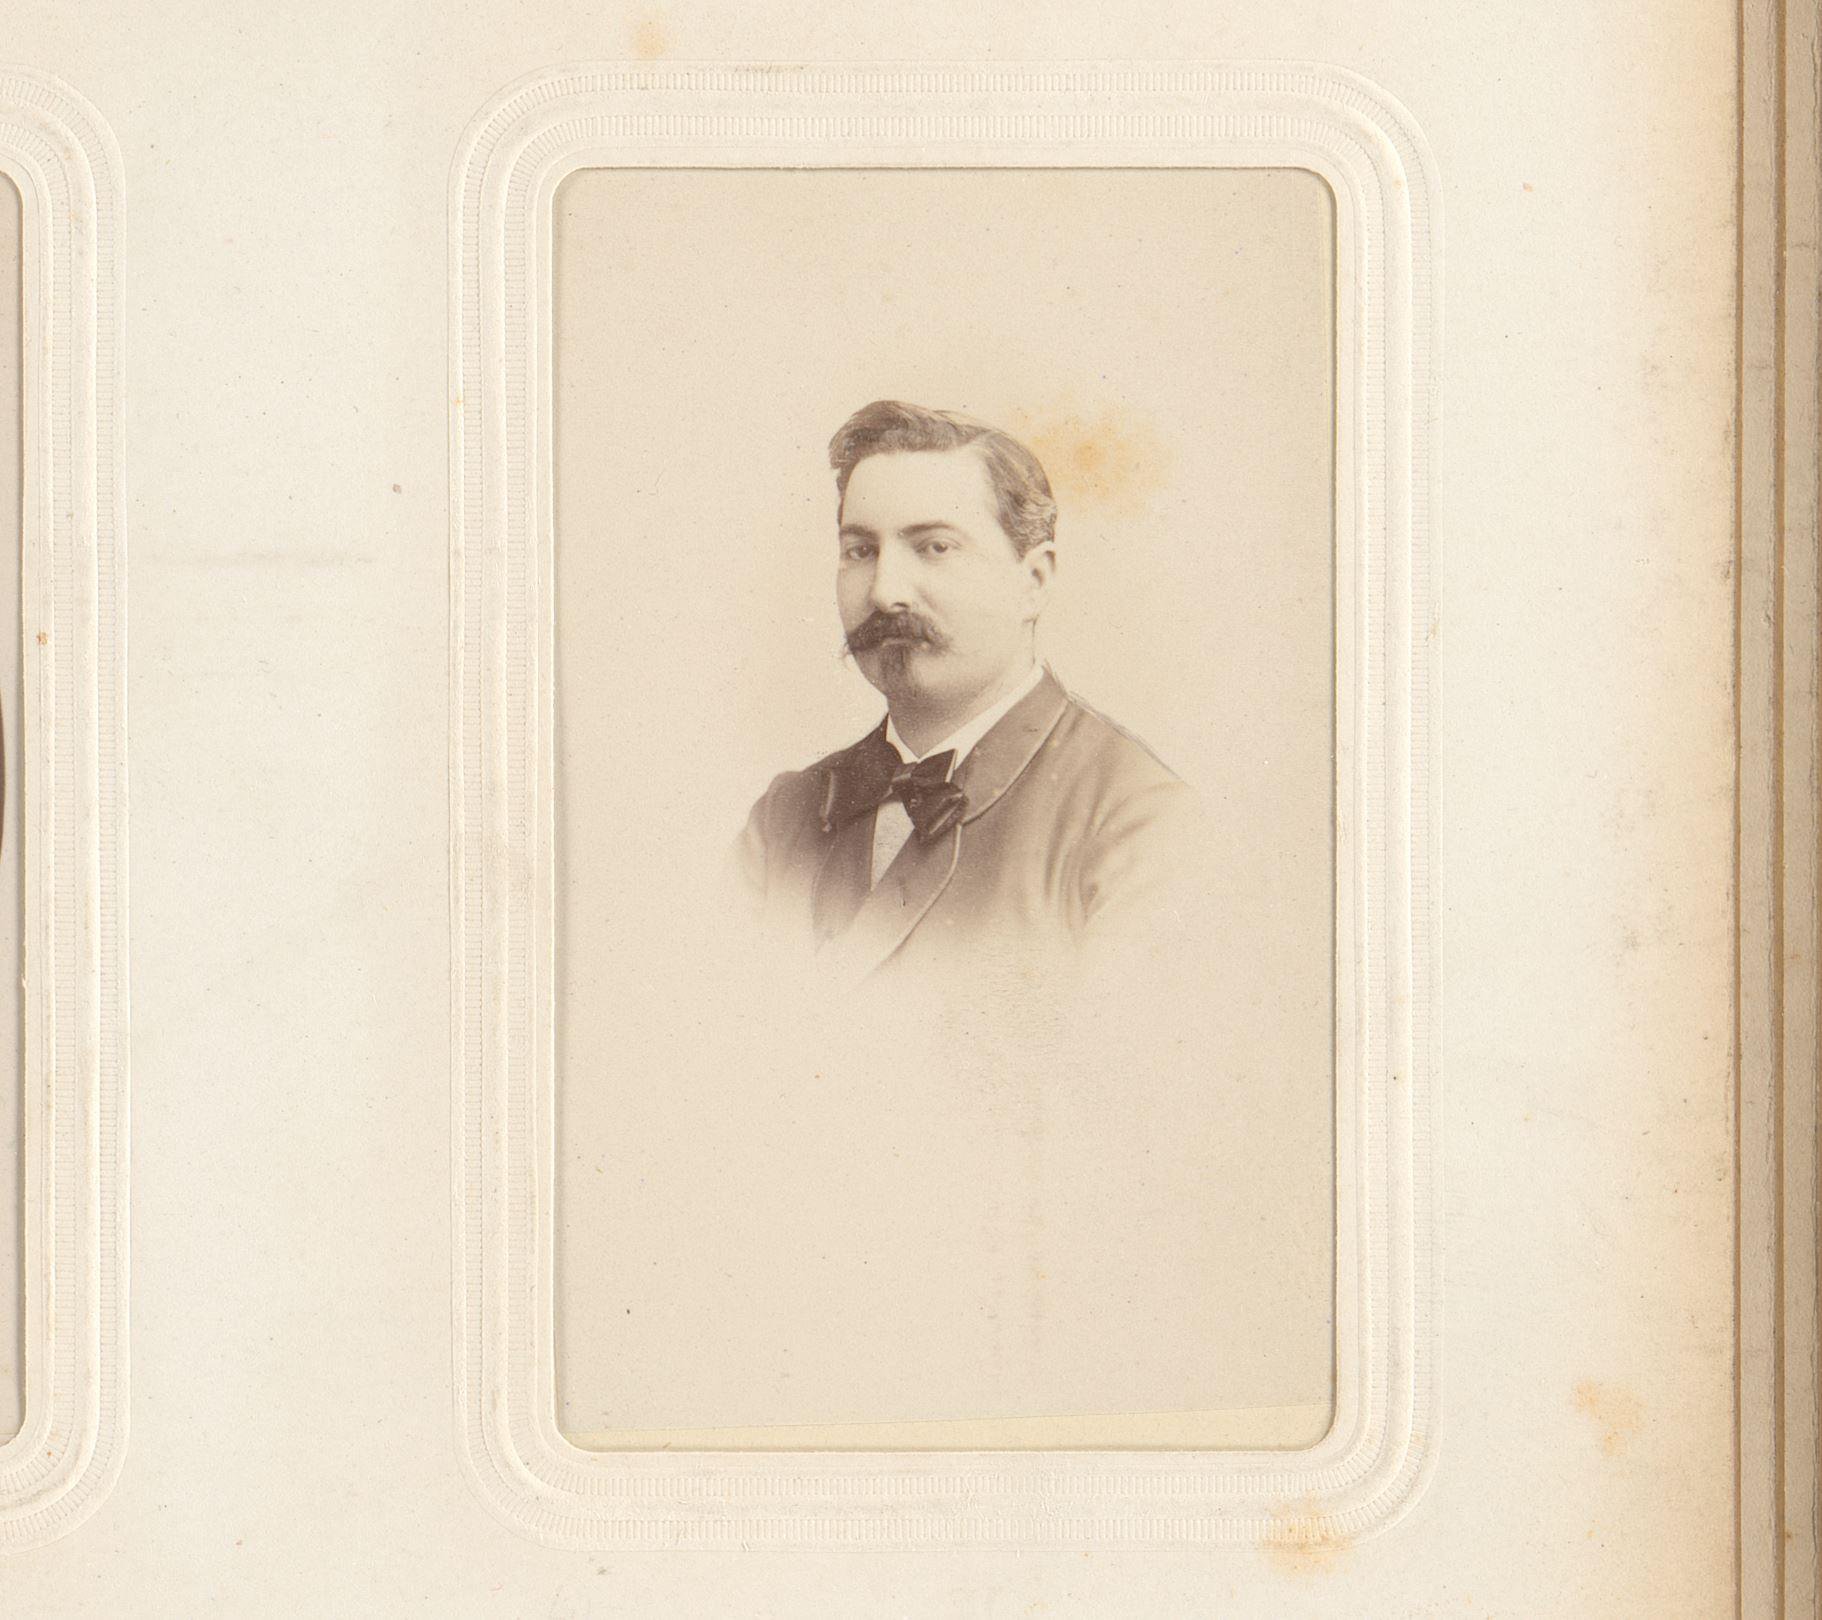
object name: album leaf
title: Portret van een man met snor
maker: Anonymous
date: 1865-1900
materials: cardboard, paper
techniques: albumen print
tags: adult man, historical persons